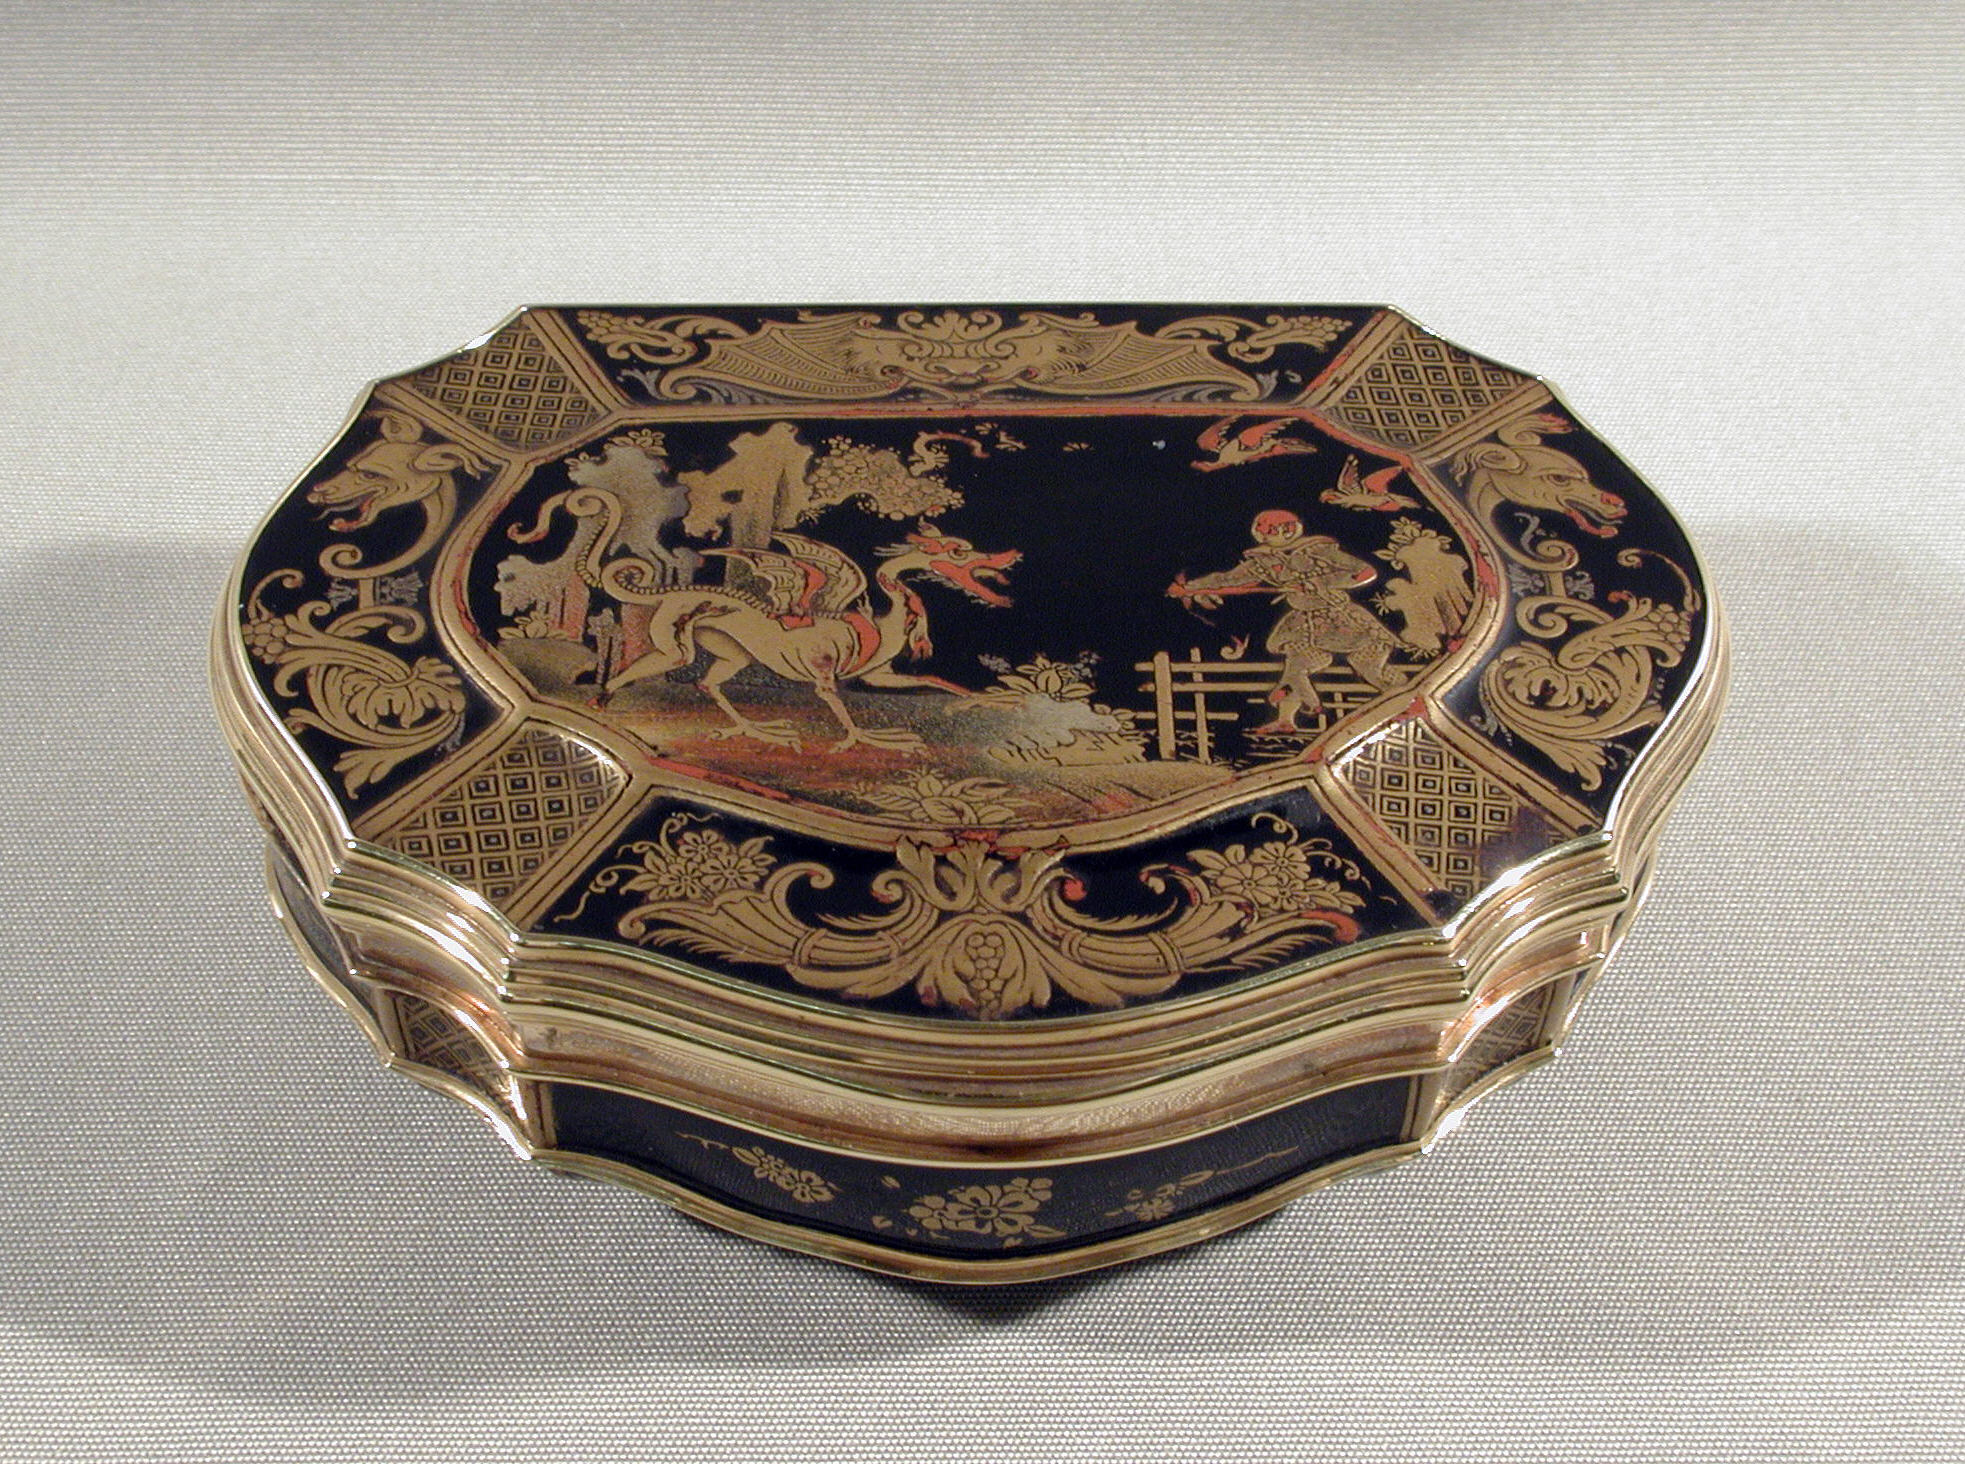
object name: snuffbox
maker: j.f.(?)b.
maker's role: maker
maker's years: 1707-1807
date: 1757-1758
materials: gold, lacquer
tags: birds,men,dragons